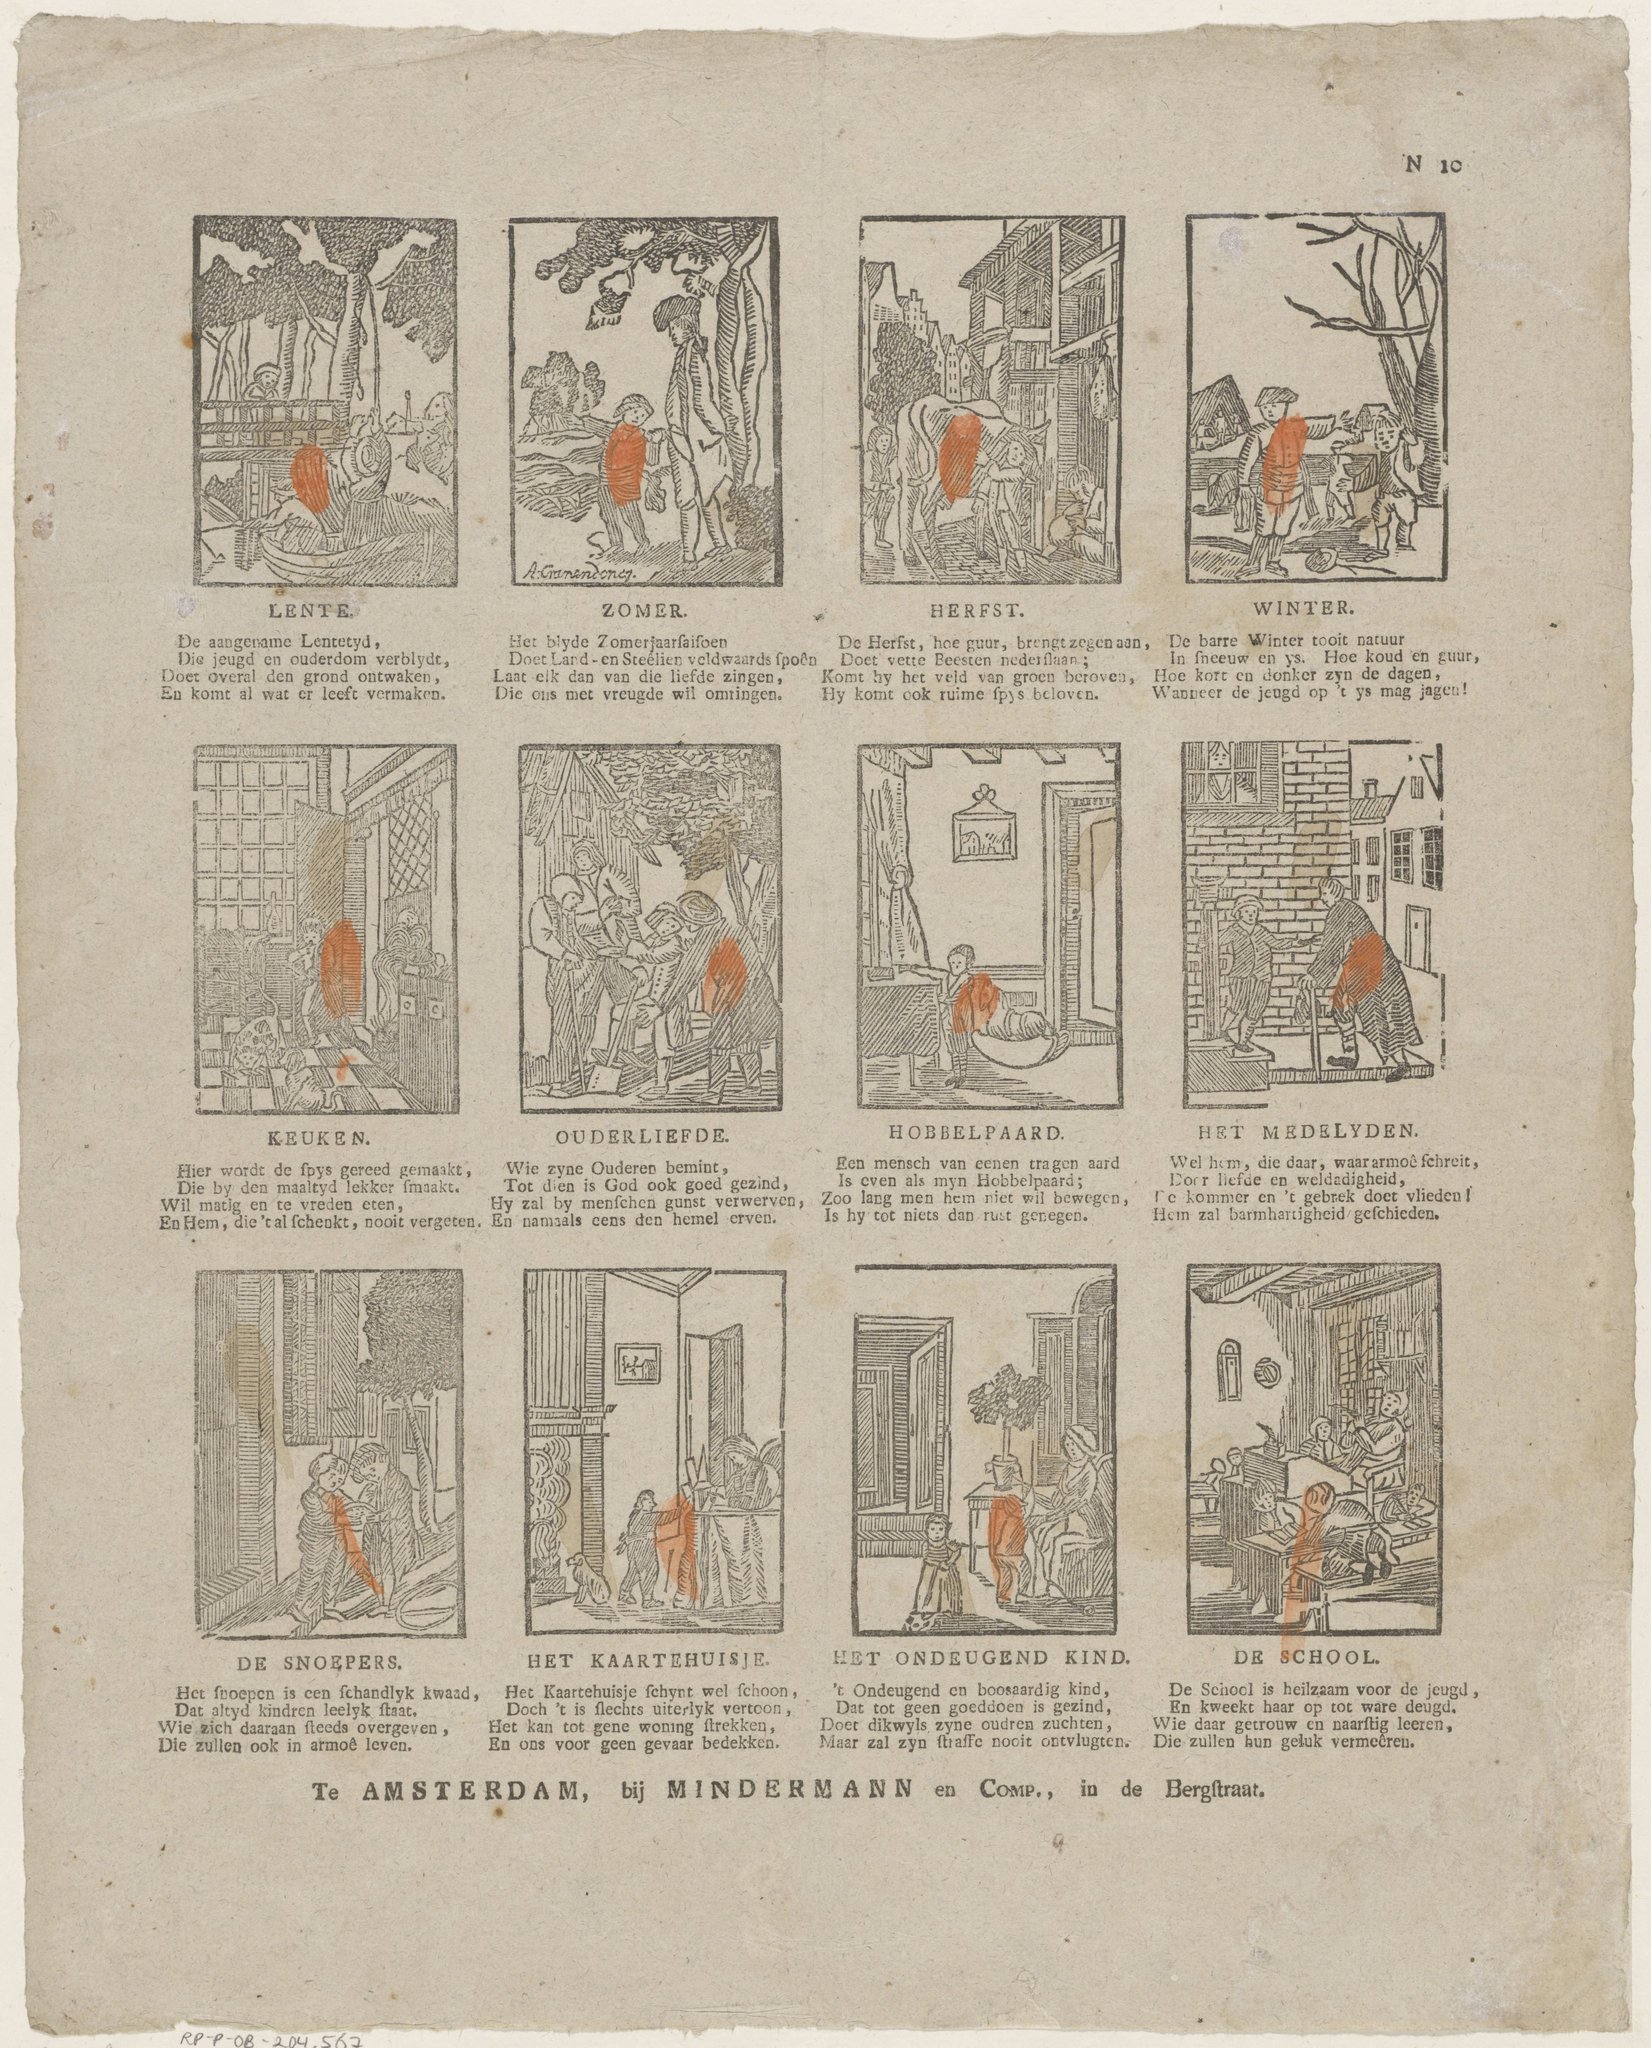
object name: print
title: Verschillende taferelen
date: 1822-1849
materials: paper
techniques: colour, letterpress printing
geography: deventer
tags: kitchen, child, bad behaviour, rocking-horse, the four seasons of the year ~ human activities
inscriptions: collector's mark: Lugt 2760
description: Blad met 12 voorstellingen van verschillende aard, waaronder verbeeldingen van de vier seizoenen en voorstellingen van een hobbelpaard en twee snoepende kinderen. Onder elke afbeelding een titel en een vierregelig vers. Genummerd rechtsboven: N 10.